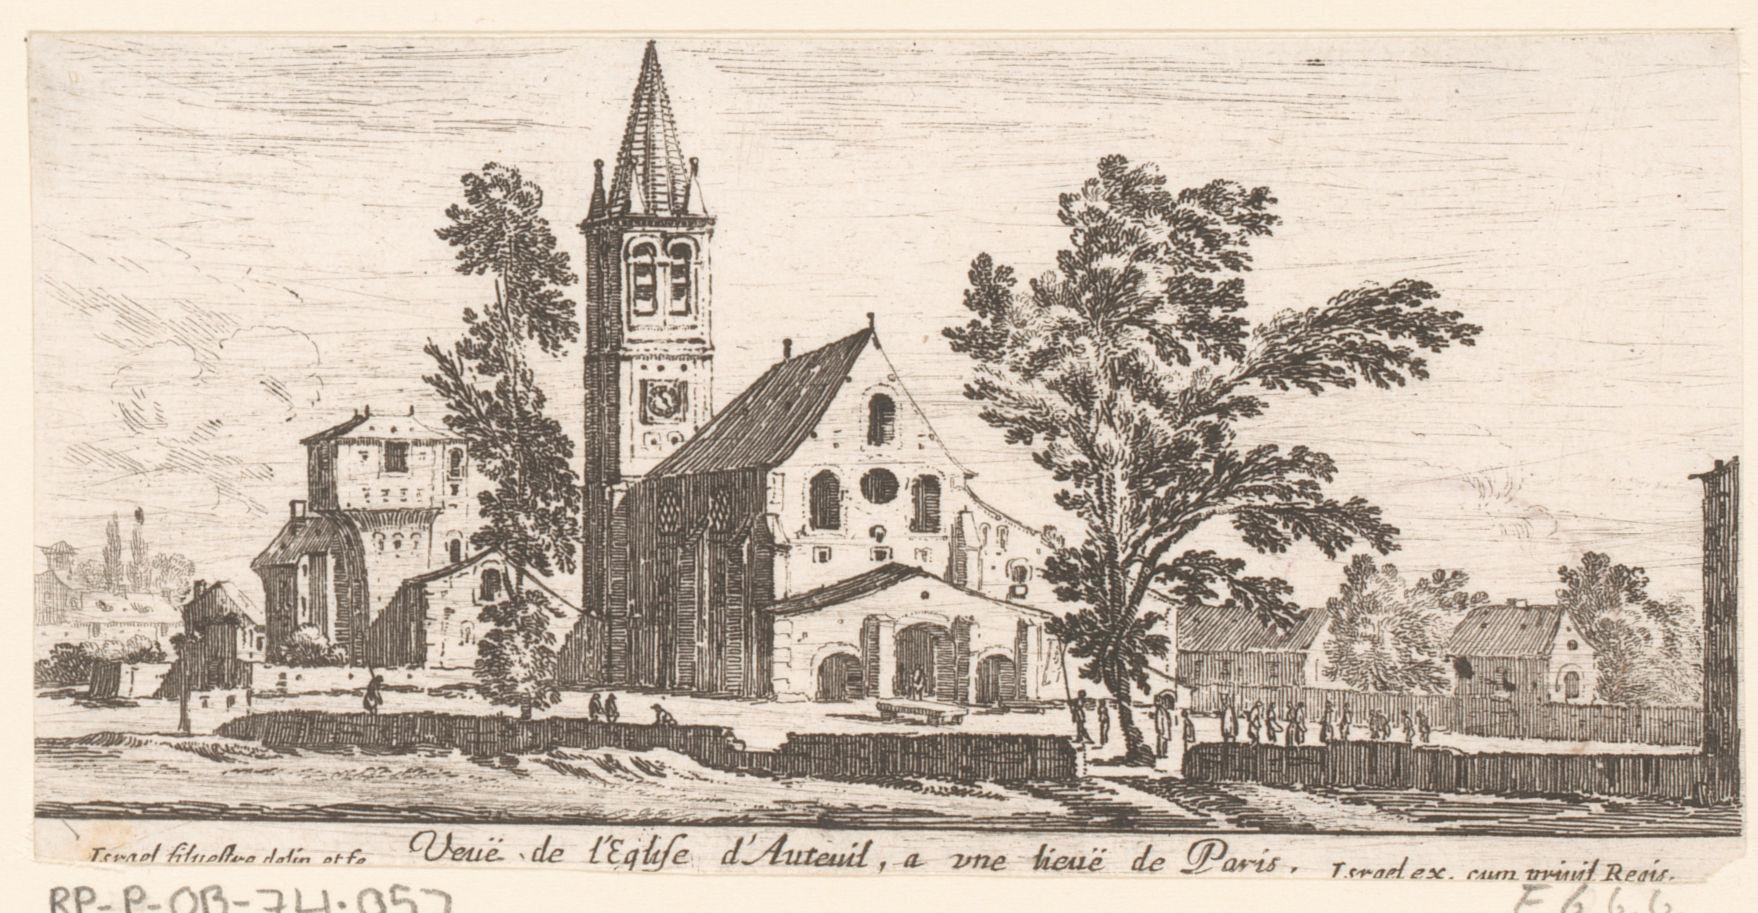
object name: print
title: Gezicht op kerken in en om Parijs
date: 1631-1661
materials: paper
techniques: etching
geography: france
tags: landscape with tower or castle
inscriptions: collector's mark: Lugt 240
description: Prent maakt deel uit van een ongenummerde serie van negen prenten.